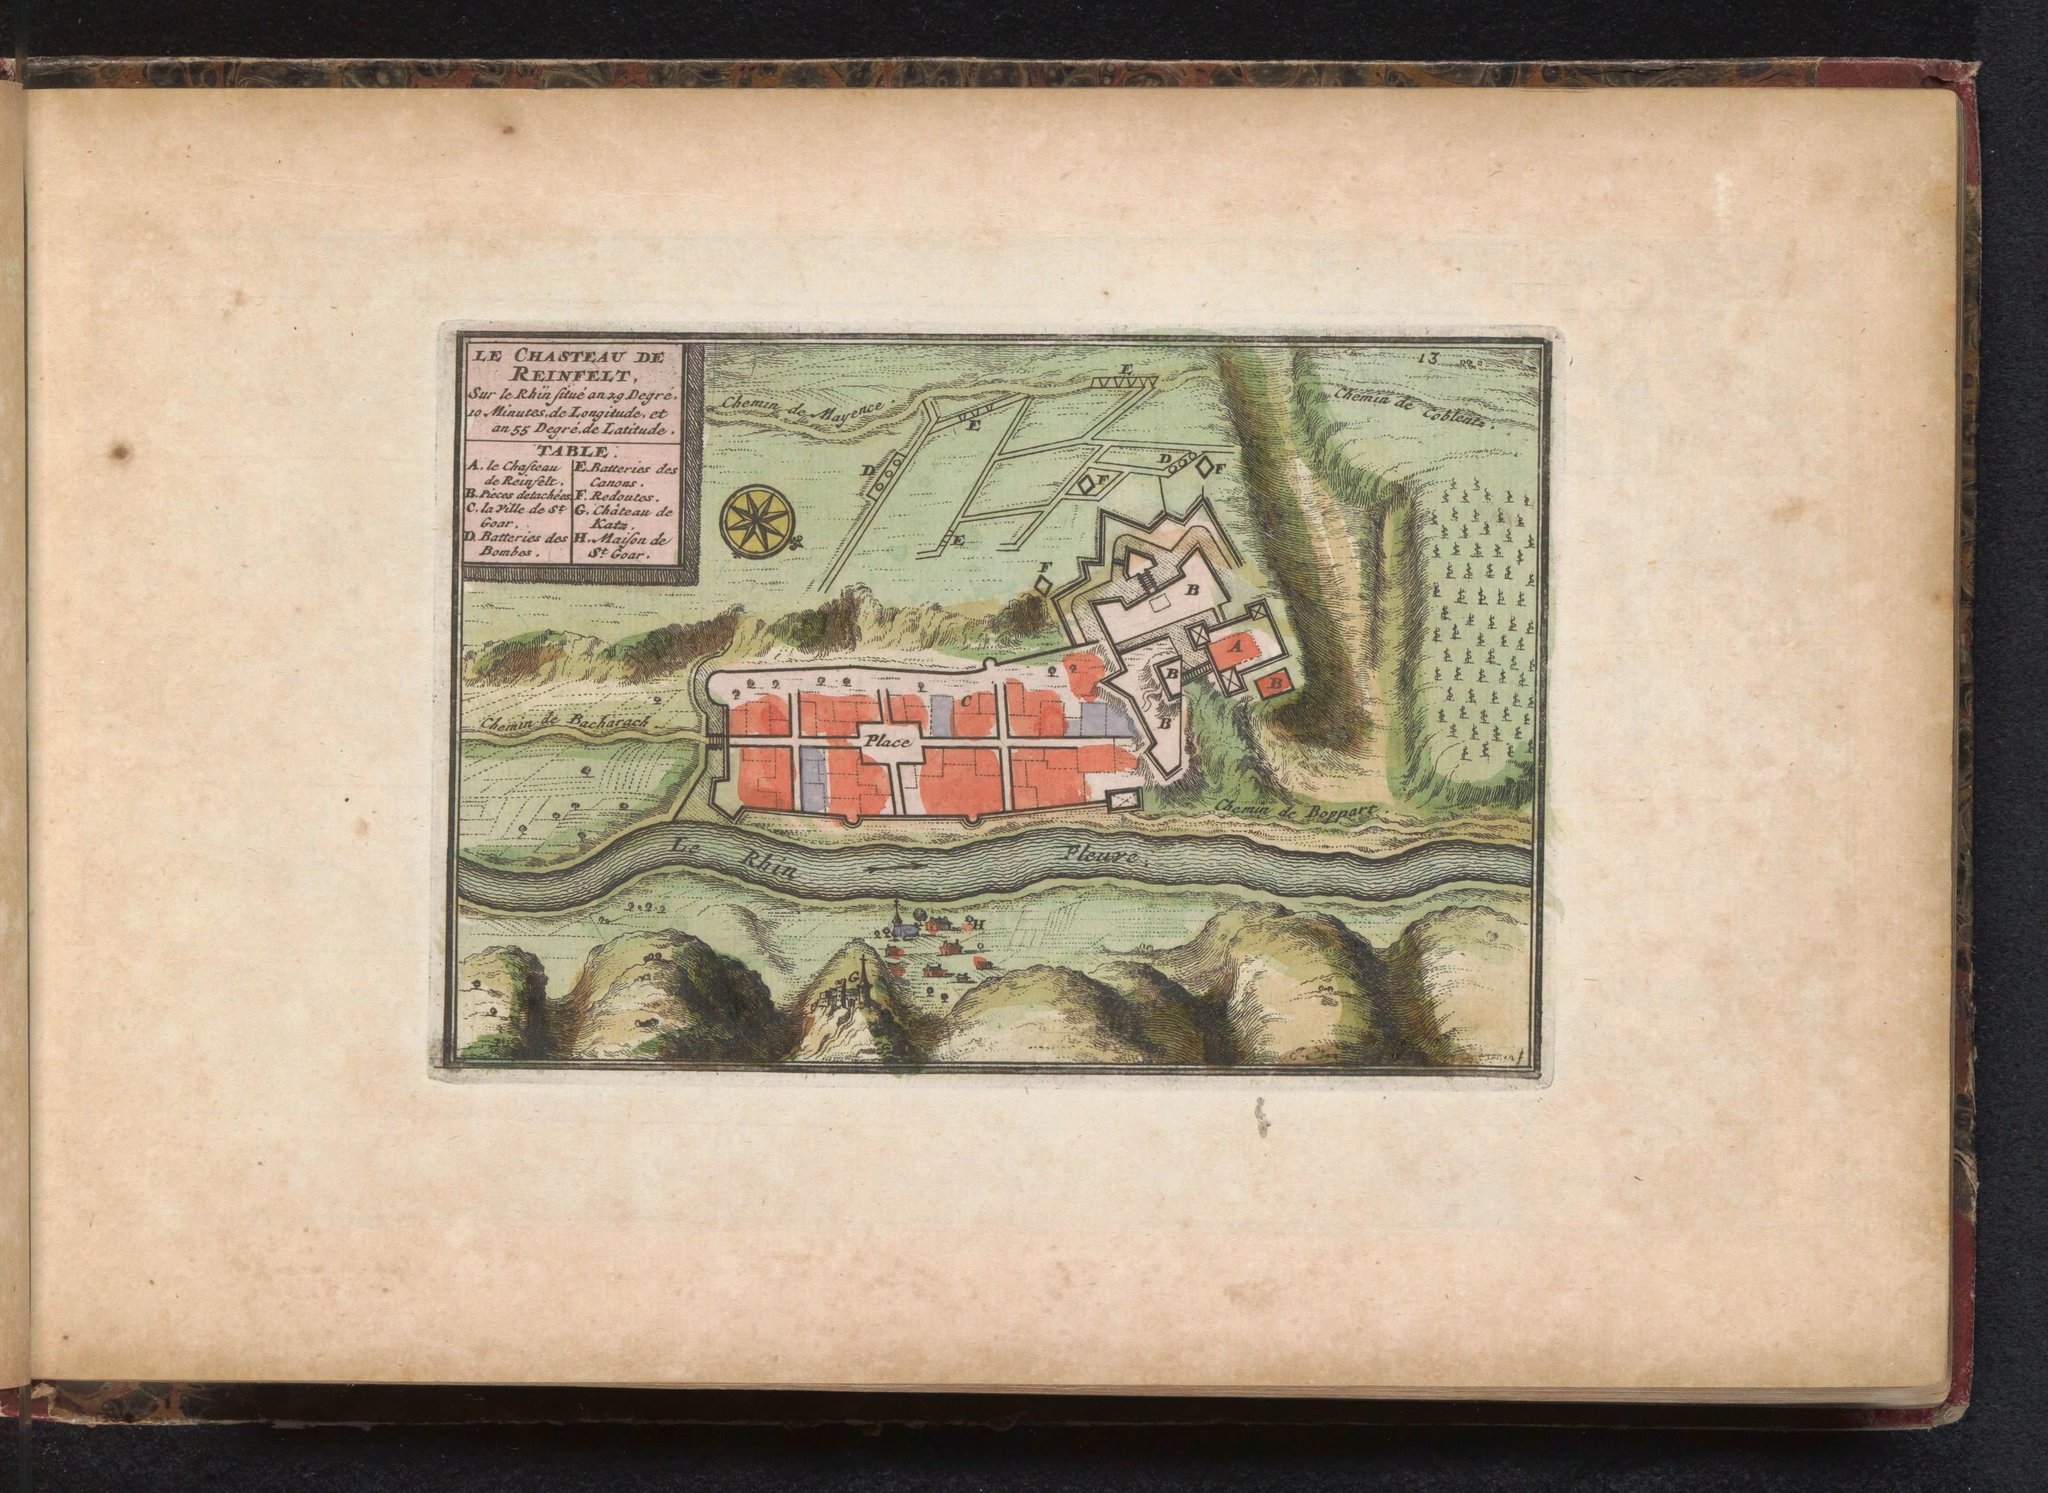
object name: map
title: Plattegrond van Rheinfels (Sankt Goar)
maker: Anonymous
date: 1700-1702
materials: paper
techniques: engraving, etching, hand coloring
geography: amsterdam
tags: maps of cities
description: Plattegrond van Rheinfels (Sankt Goar). Onderdeel van een atlas met 223 kaarten van landen en steden en oorlogstaferelen in Europa in de periode ca. 1690-1735.